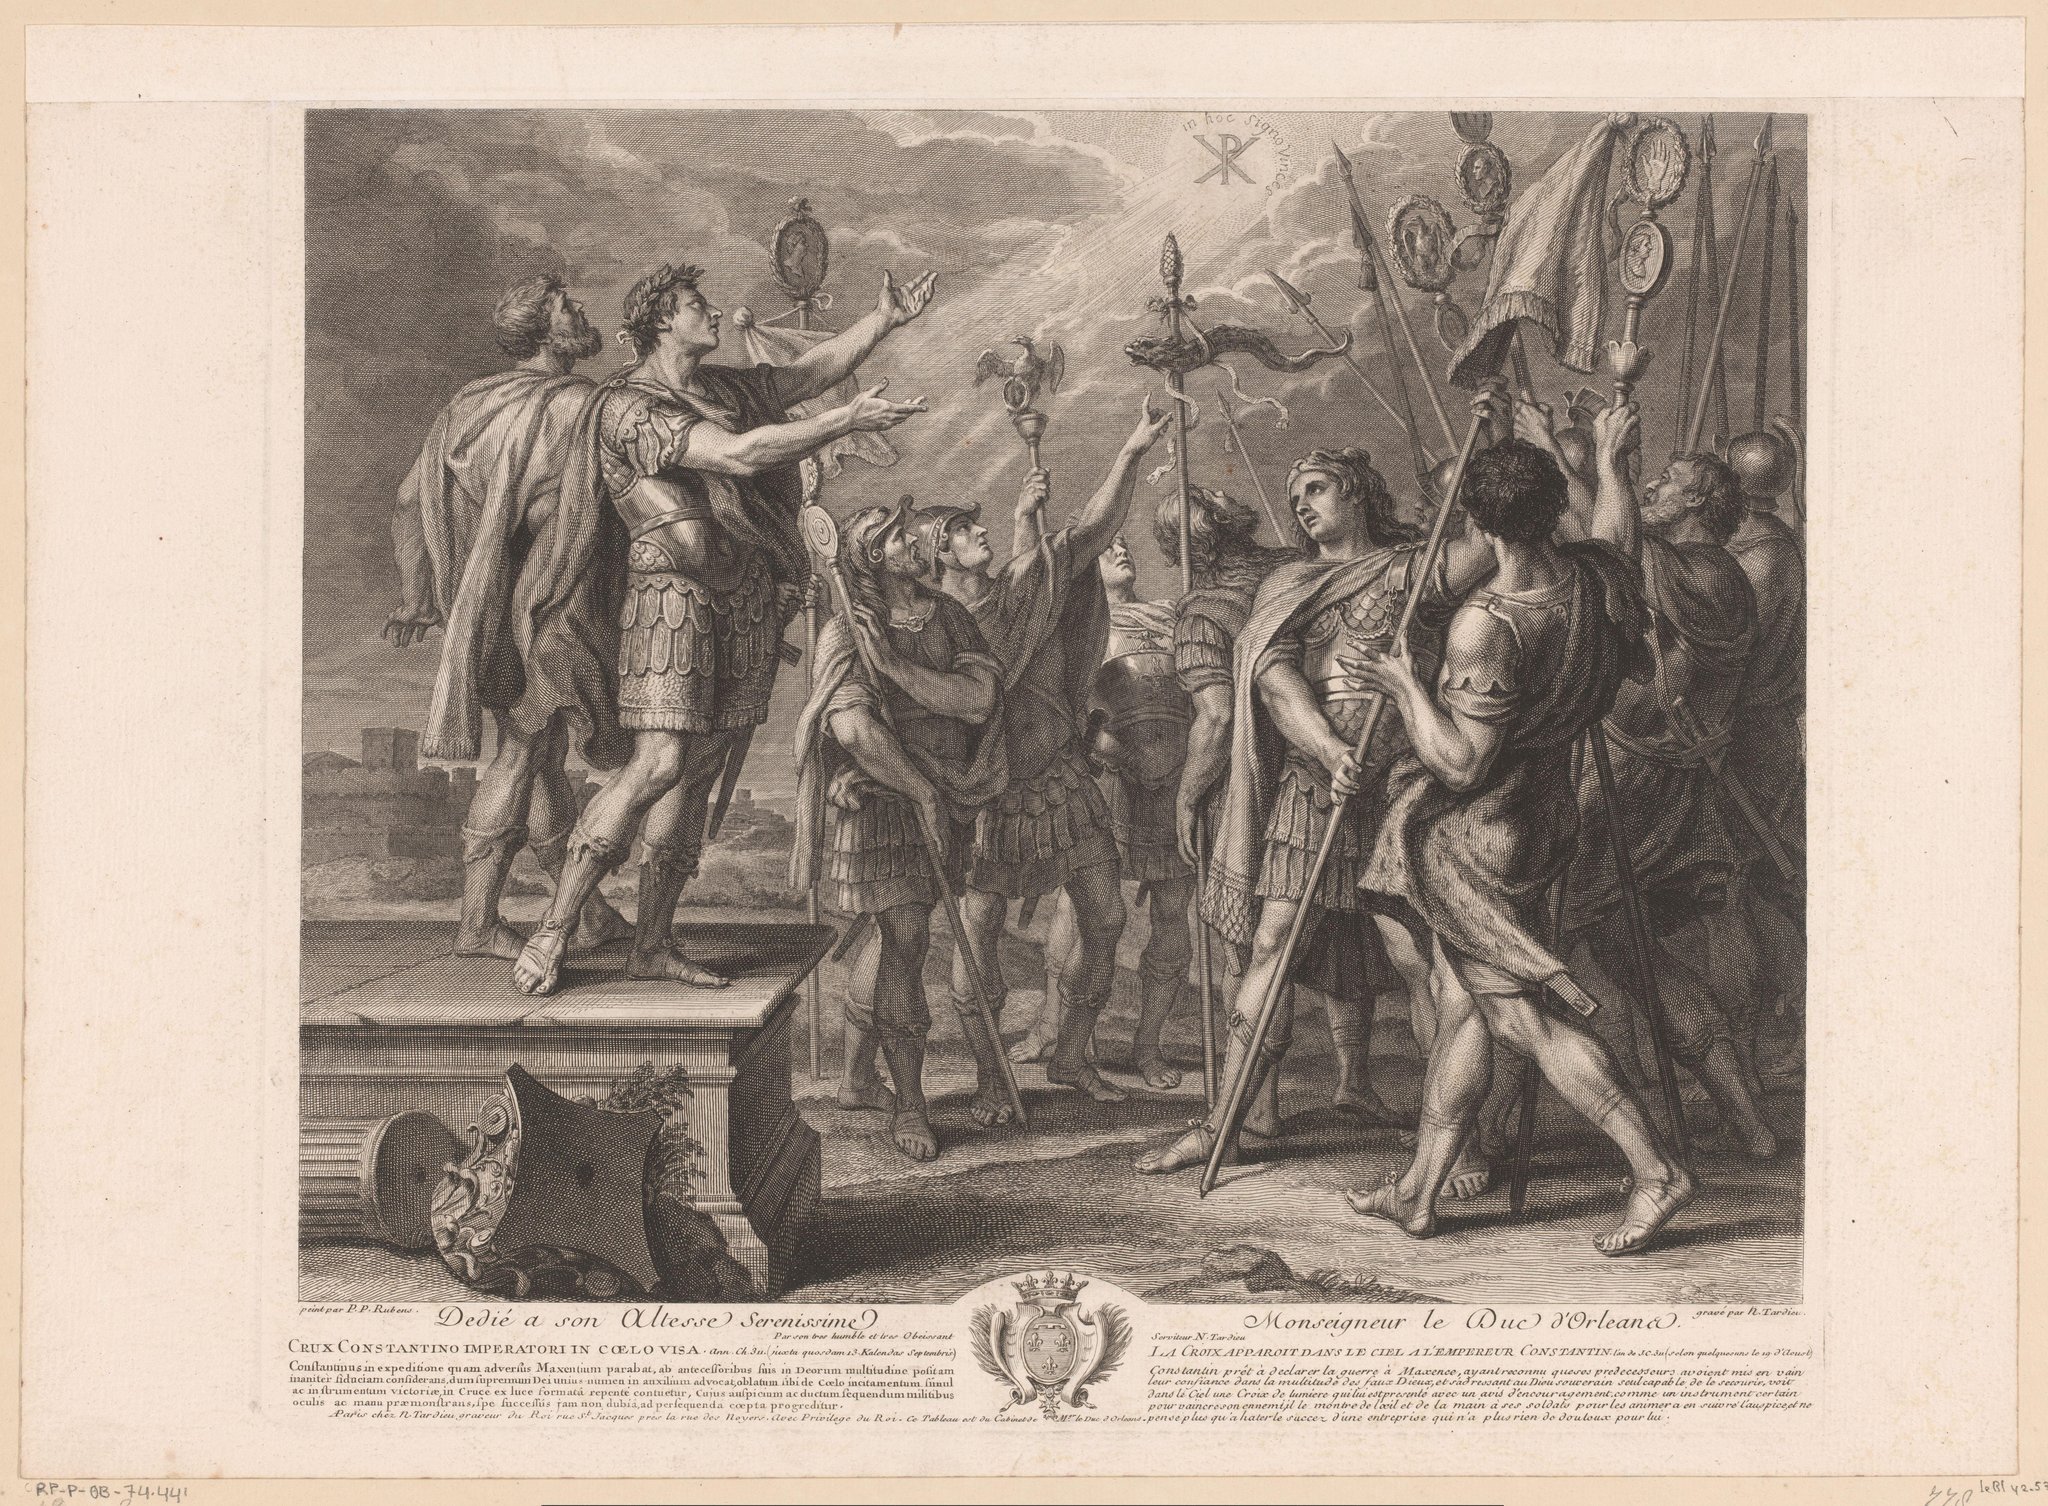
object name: print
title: Crux Constantino imperatori in coelo visa / La croix apparoit dans le ciel a l'empereur Constantin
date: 1684-1749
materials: paper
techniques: engraving, etching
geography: paris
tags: the battle of the milvian bridge (saxa rubra): st. constantine on horseback confronts maxentius; a cross appears in the sky with in fiery letters 'in hoc signo vinces' (the raised standards of the roman soldiers carry a cross or the chi-rho monogram)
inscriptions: collector's mark: Lugt 240